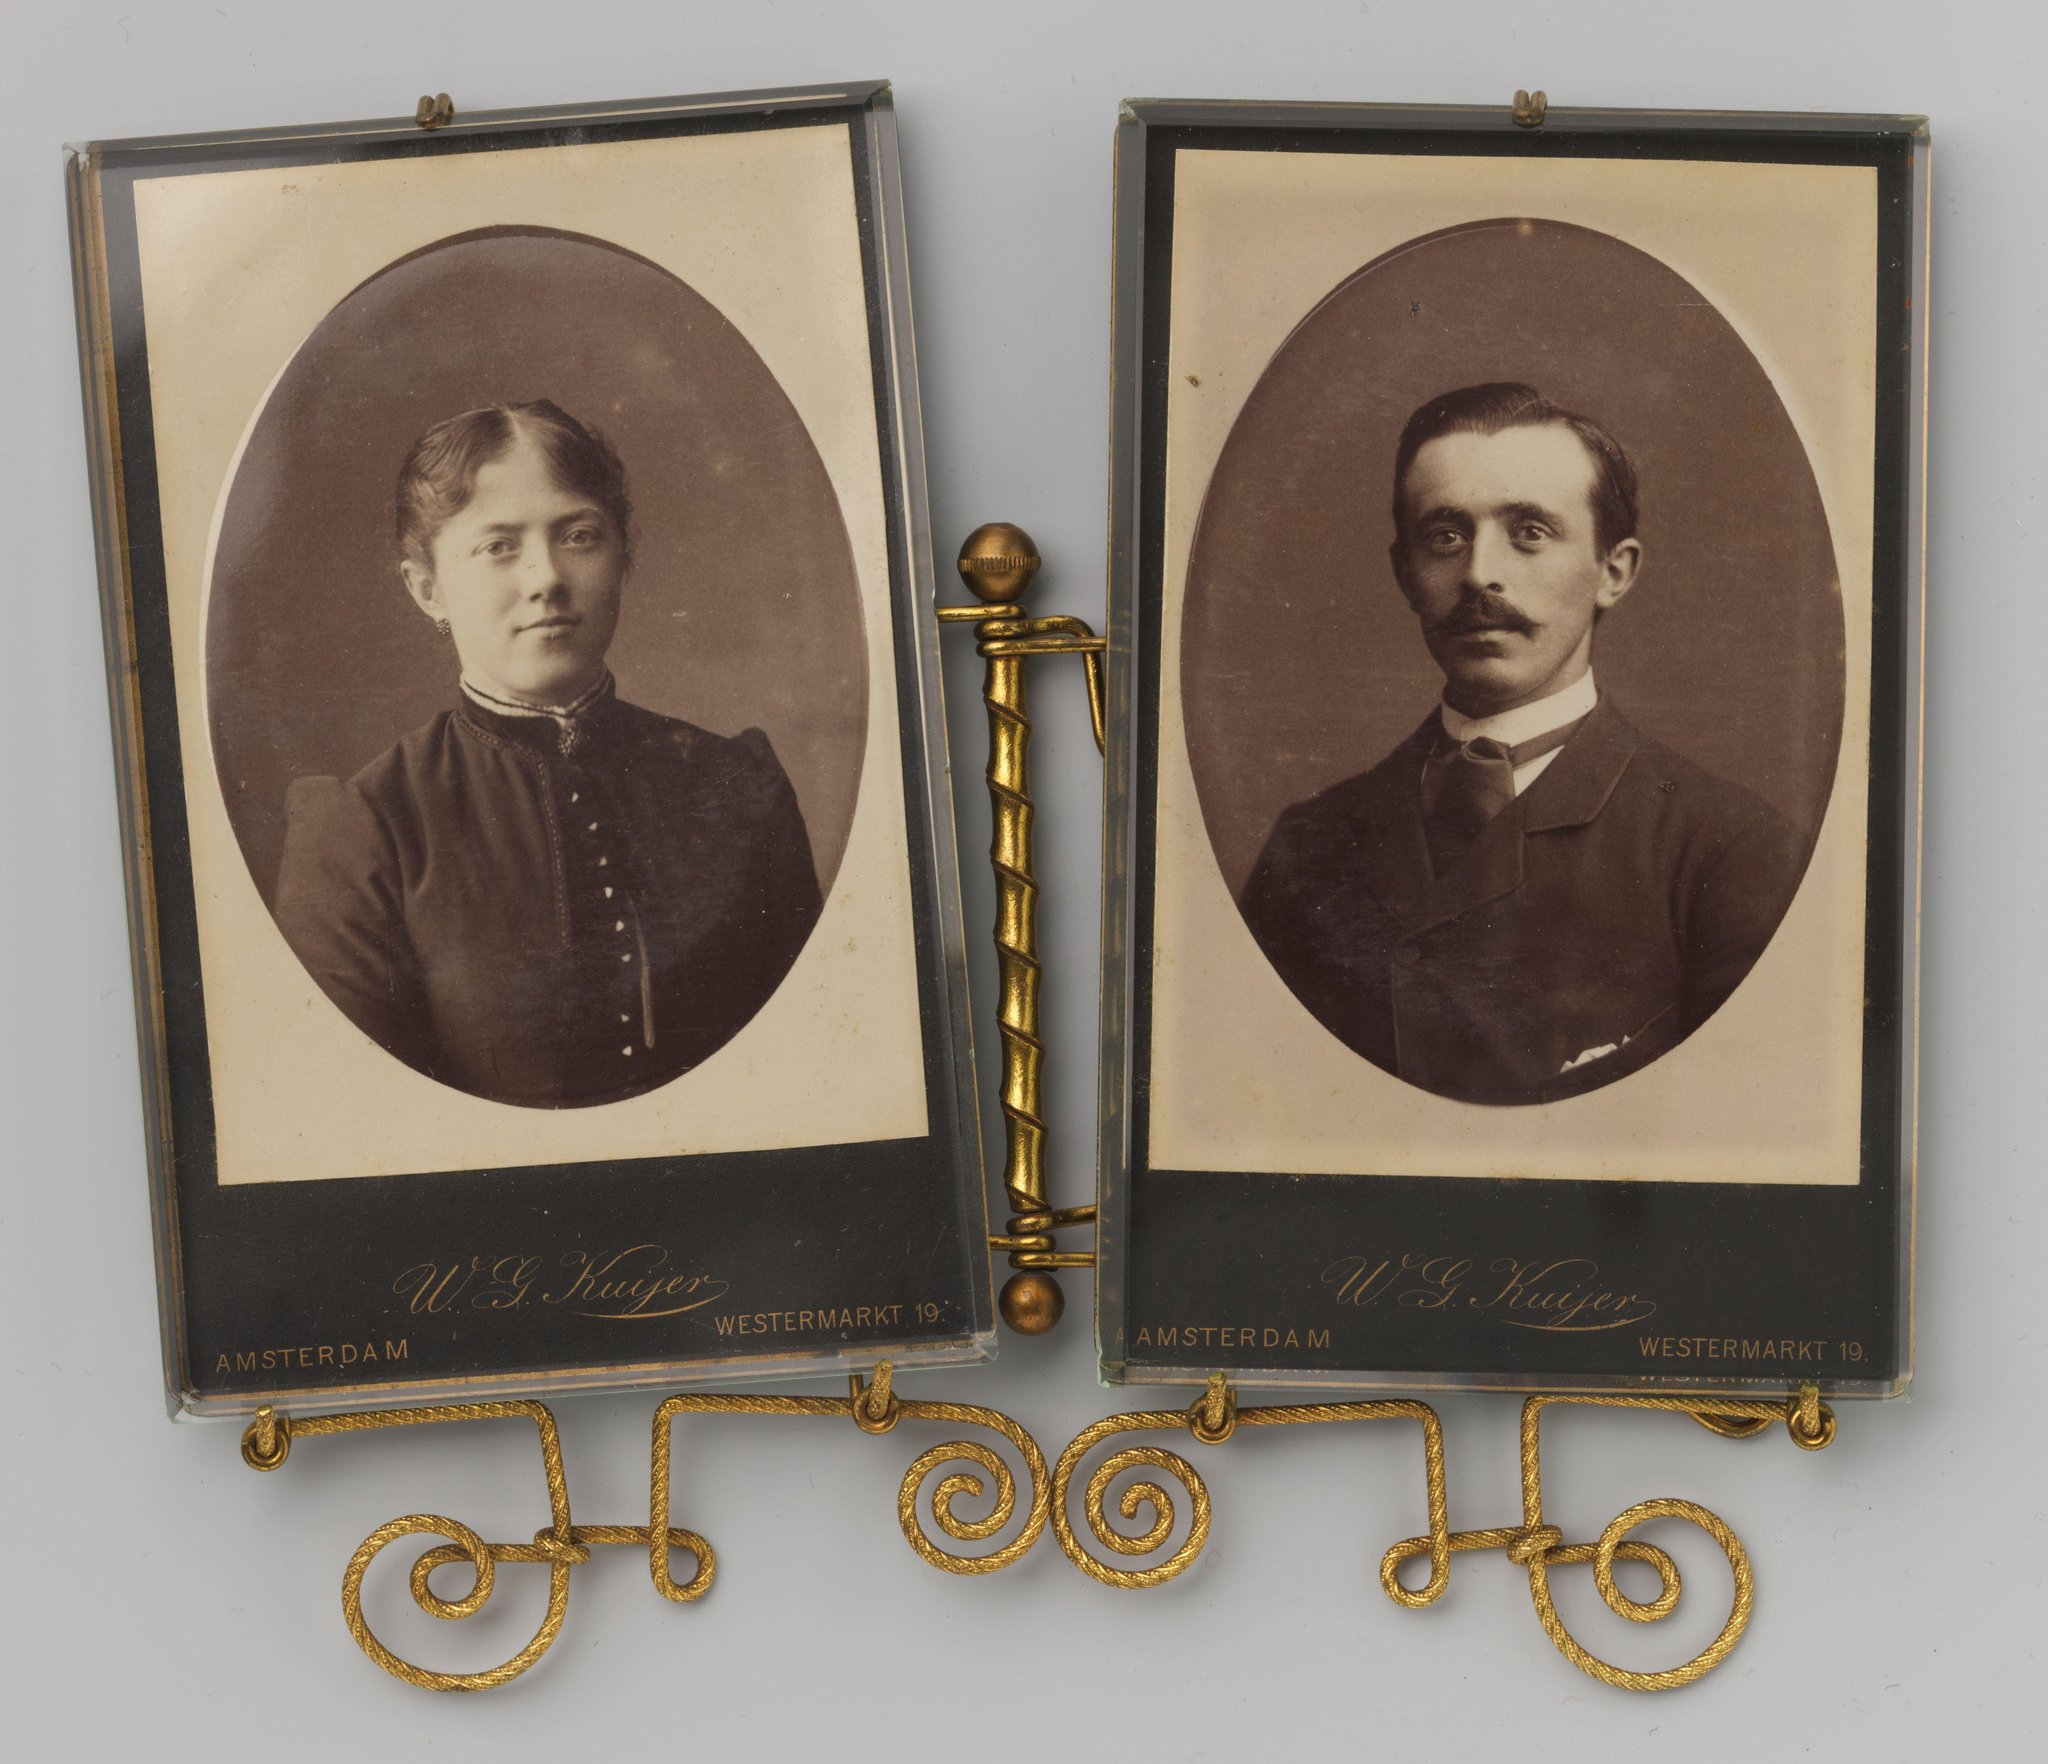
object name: cabinet photograph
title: Portret van een onbekende man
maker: willem gerhardus kuijer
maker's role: fotograaf, hoffotograaf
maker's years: 1834-1899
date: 1880-1906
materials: cardboard, paper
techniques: albumen print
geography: amsterdam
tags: adult man, anonymous historical person portrayed, amsterdam